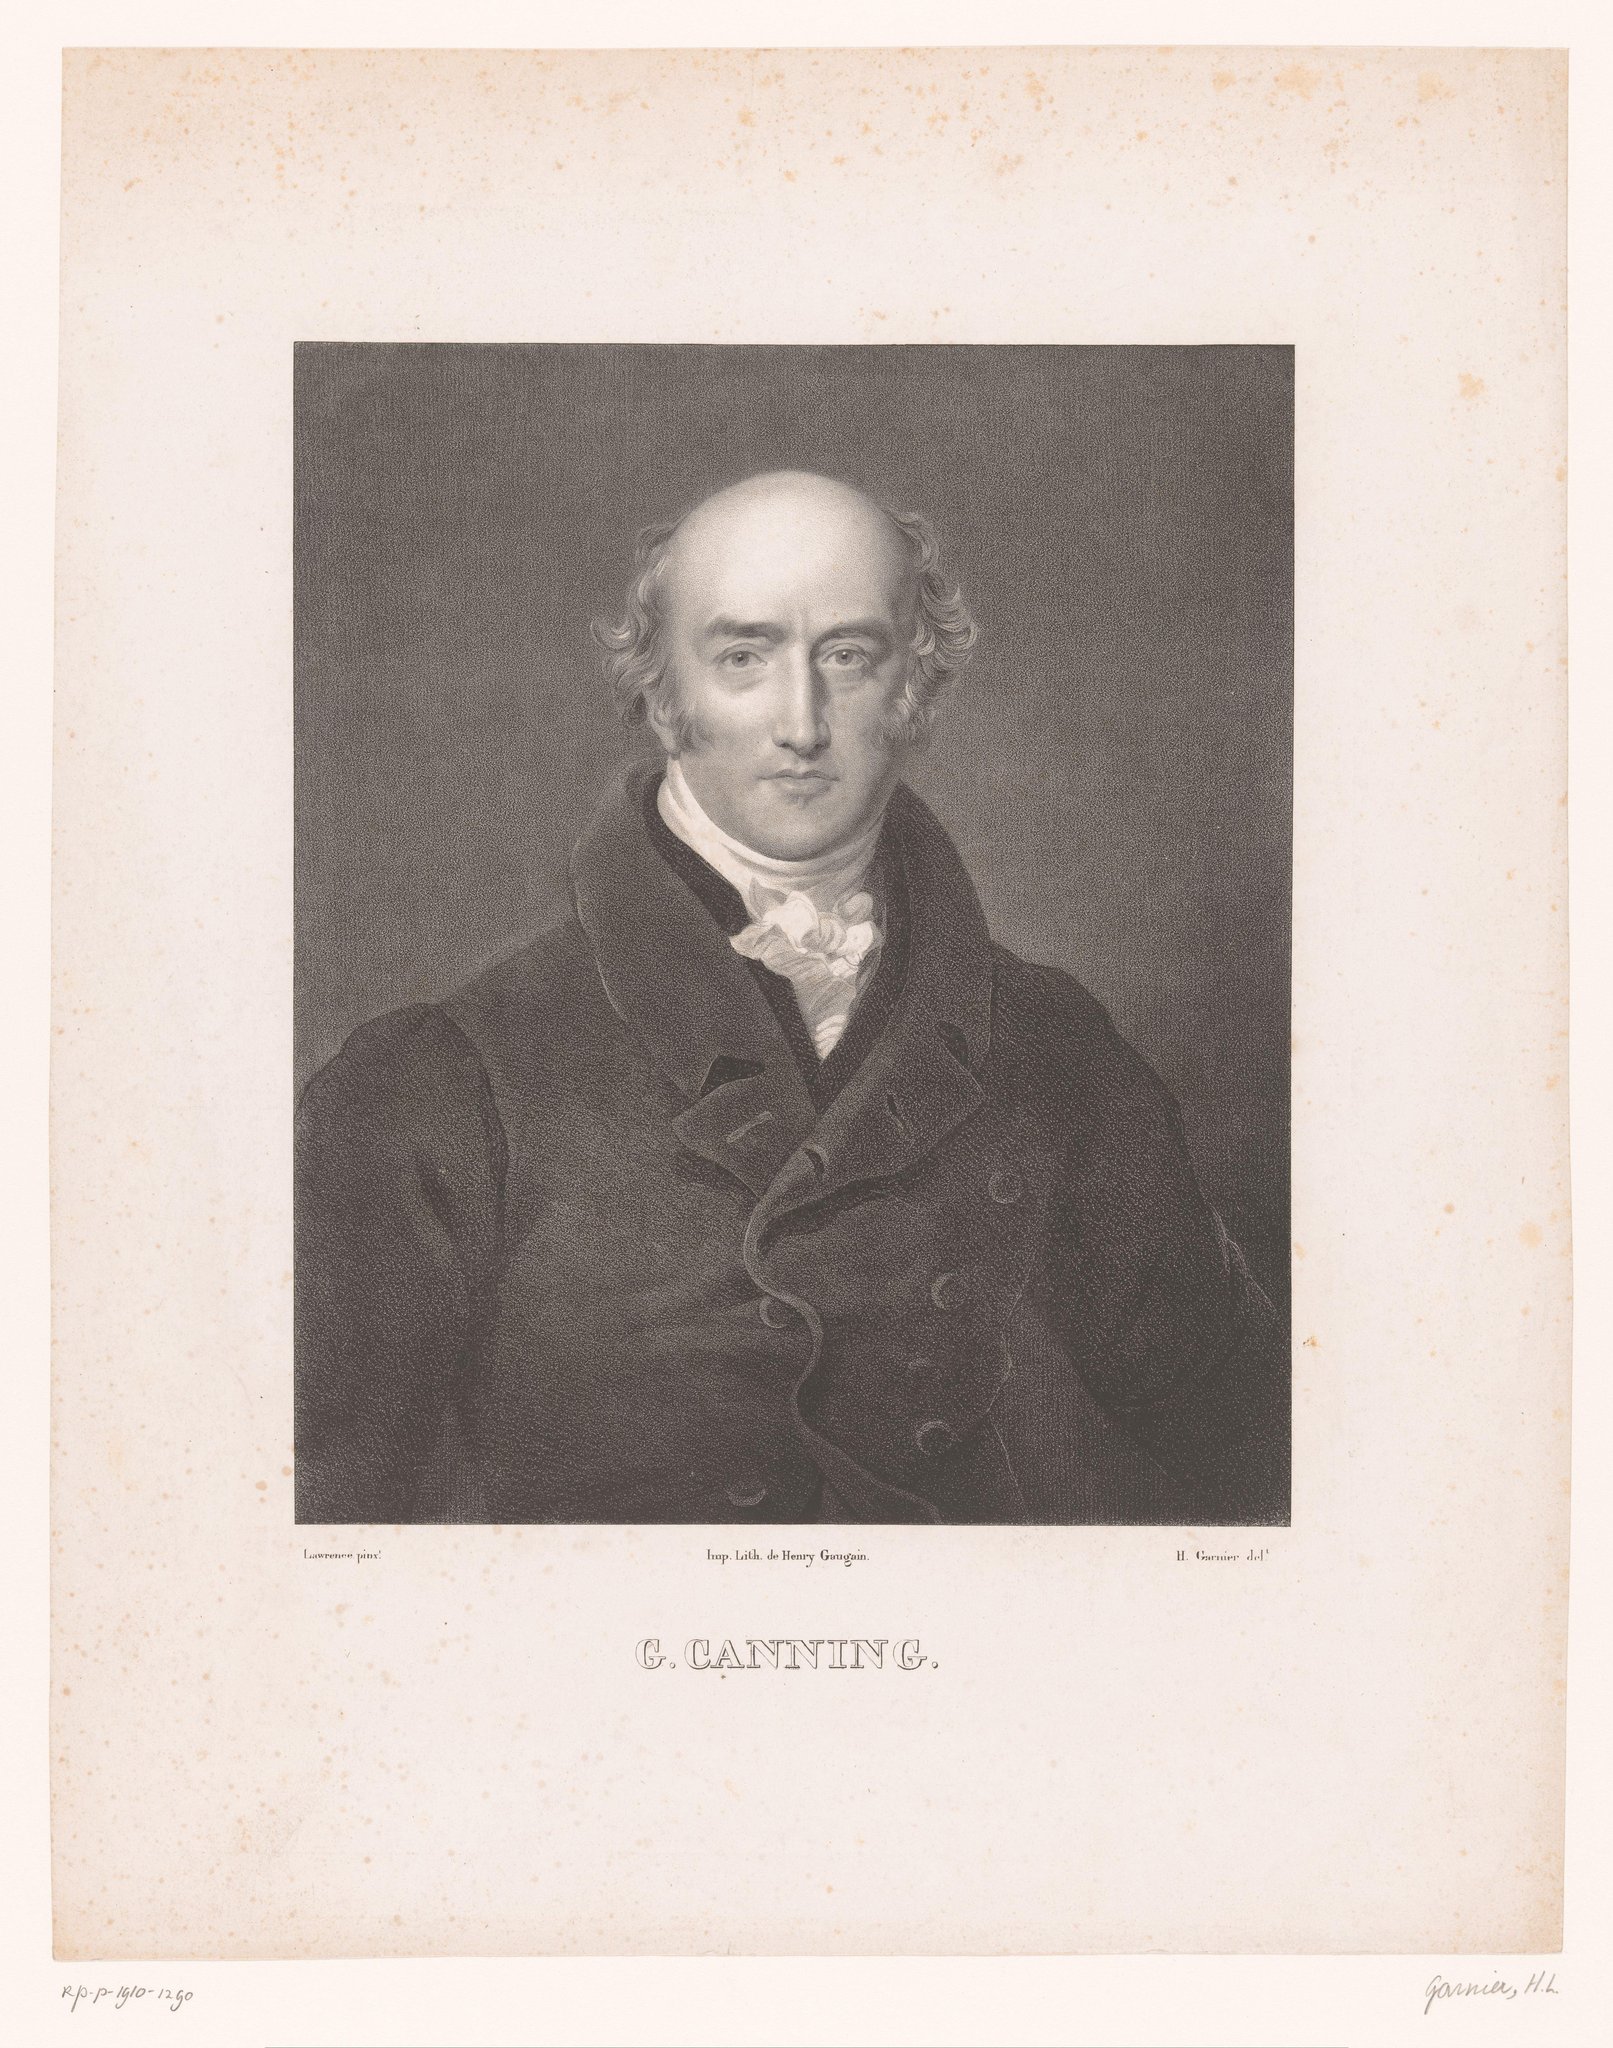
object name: print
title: G. Canning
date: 1827-1830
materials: paper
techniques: lithograph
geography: paris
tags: historical persons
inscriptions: collector's mark: Lugt 2228a